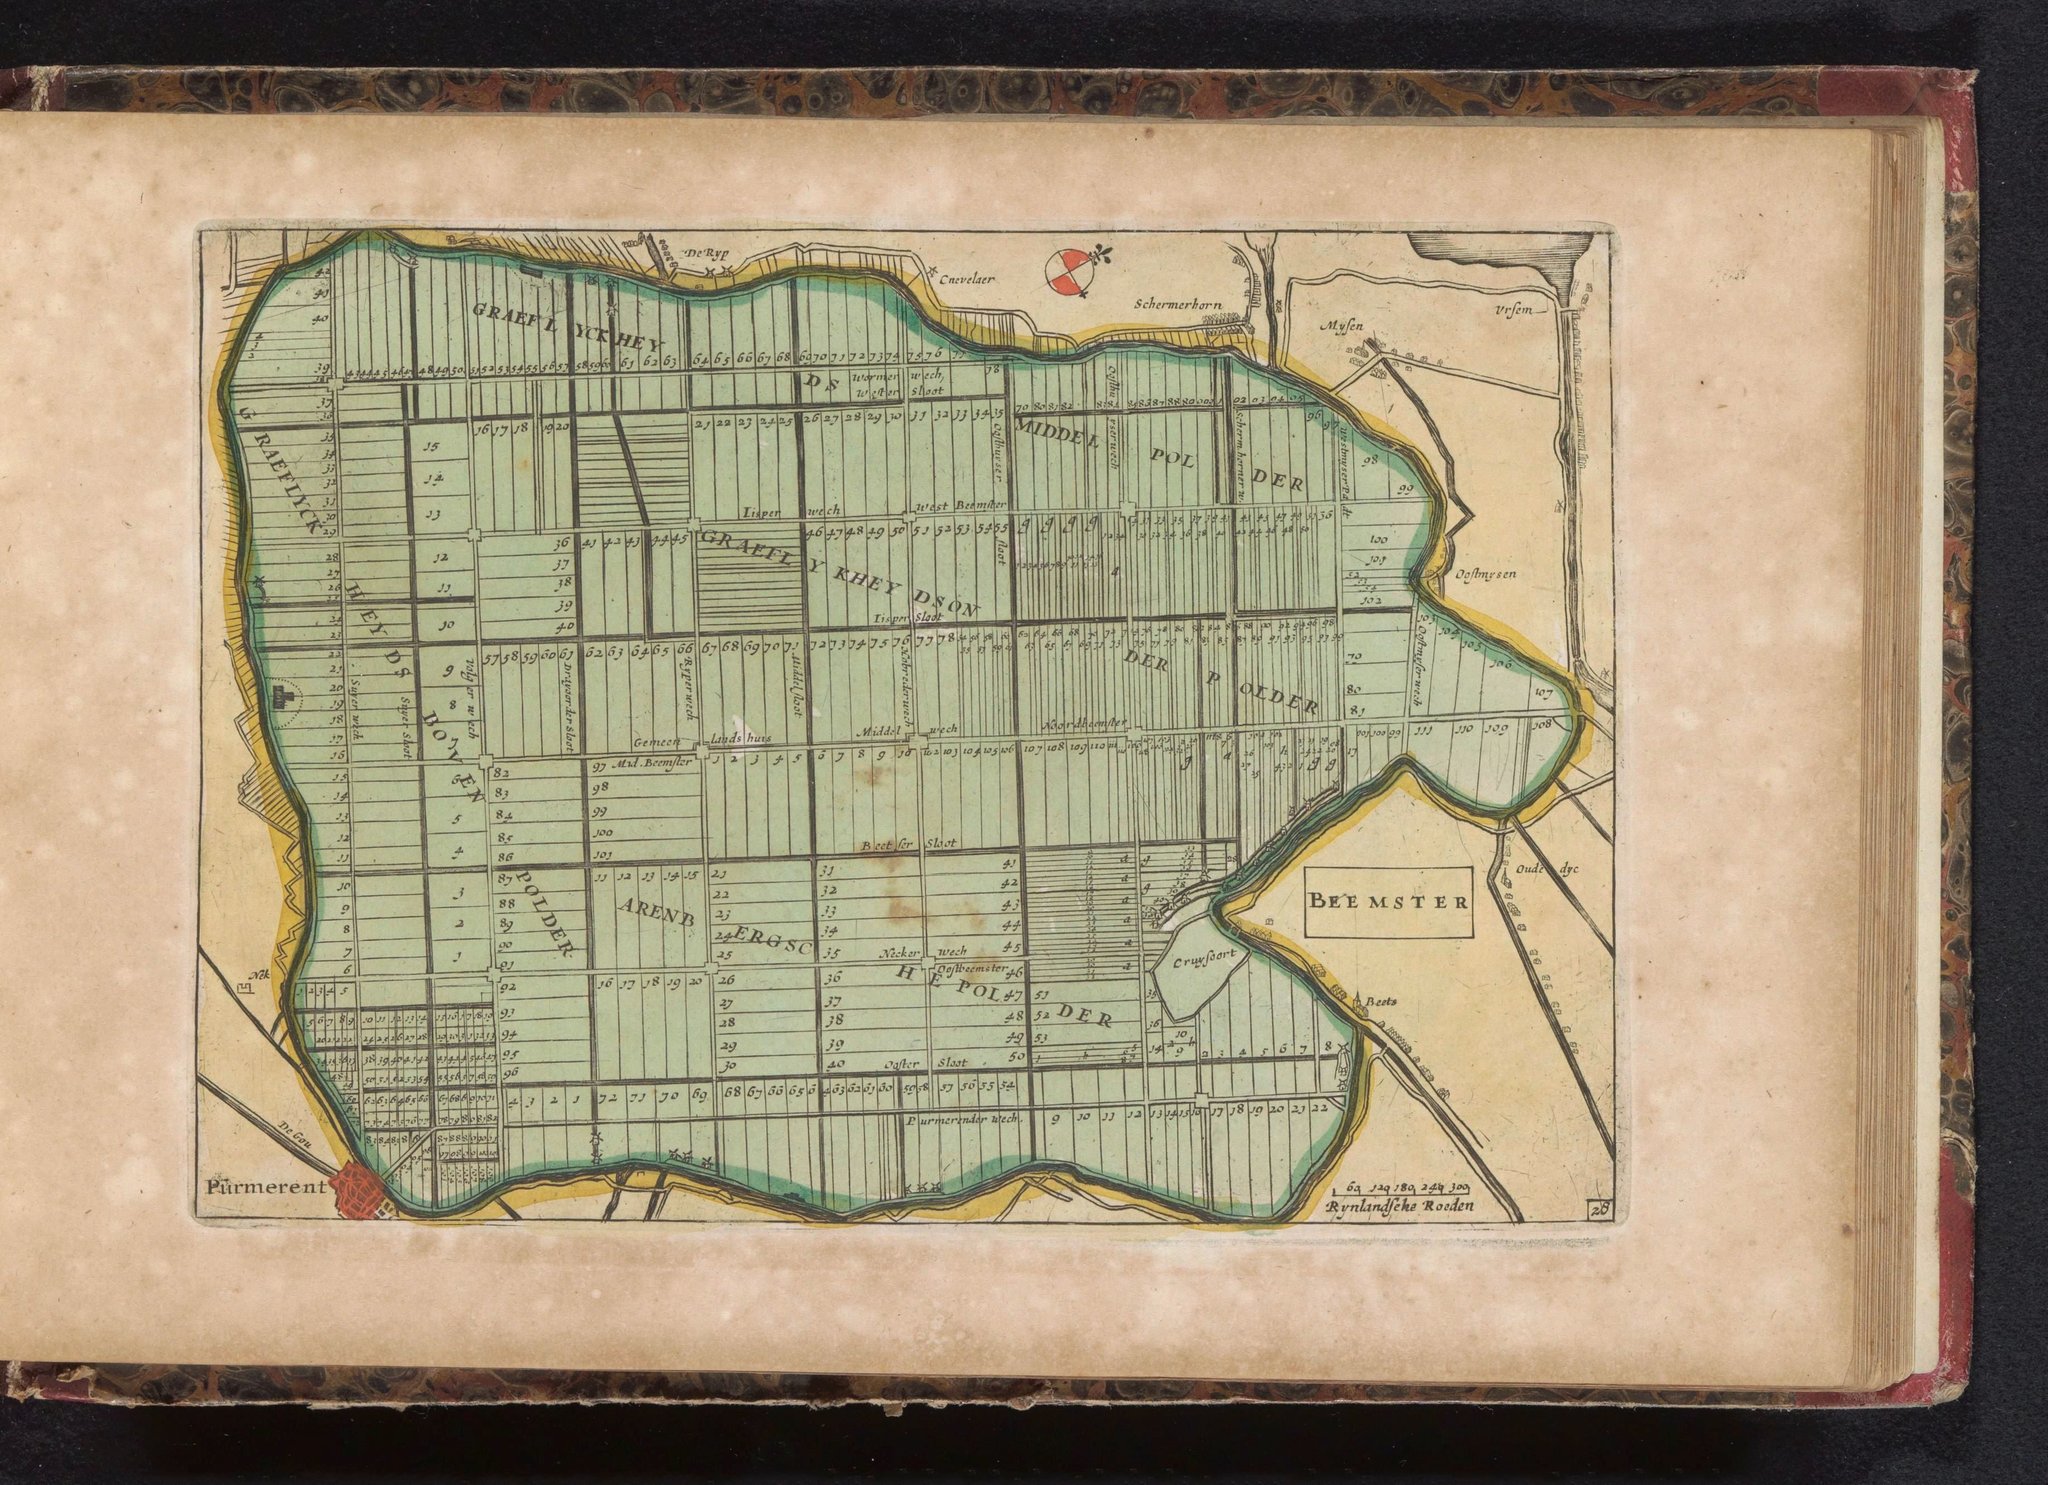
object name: map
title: Kaart van de ingepolderde Beemster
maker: Anonymous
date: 1700-1702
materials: paper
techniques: engraving, hand coloring, lacquer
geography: northern netherlands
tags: maps of separate countries or regions, polder, reclaimed land, beemster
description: Kaart van de ingepolderde Beemster. Onderdeel van een atlas met 223 kaarten van landen en steden en oorlogstaferelen in Europa in de periode ca. 1690-1735.